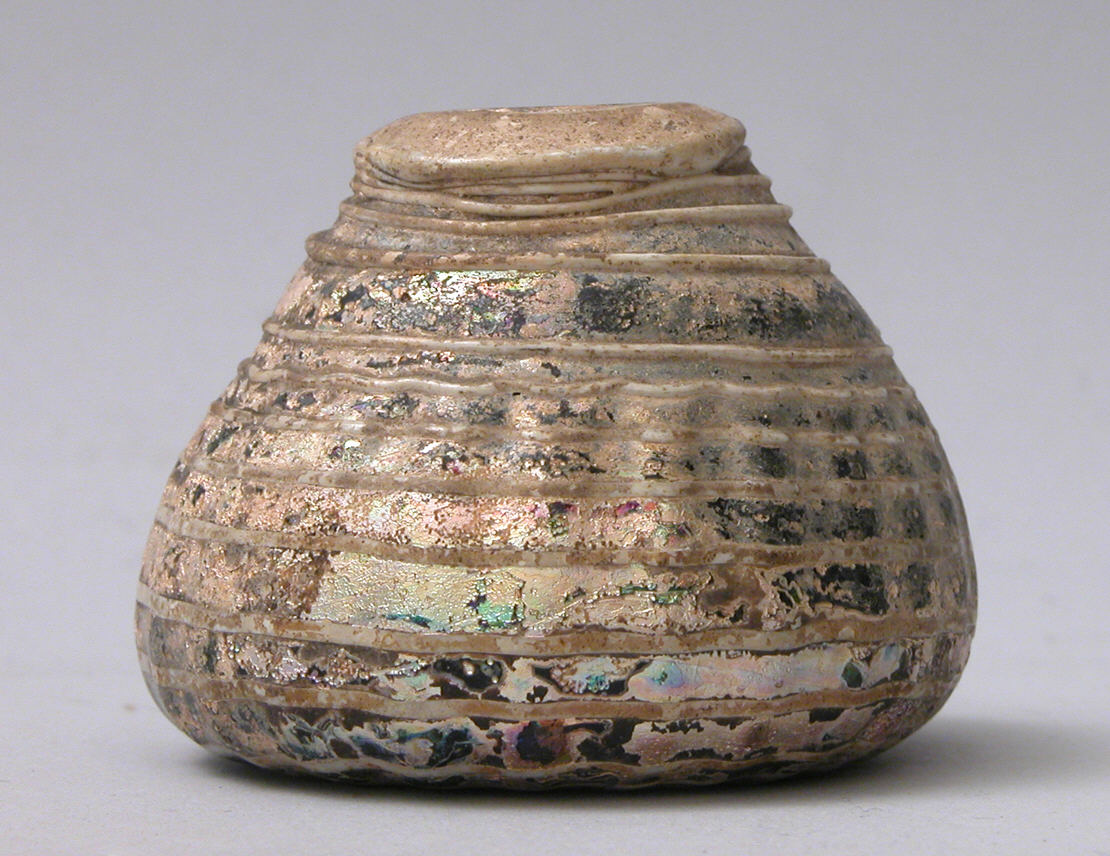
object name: inkwell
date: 1201-1300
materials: glass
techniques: glassblowing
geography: syria